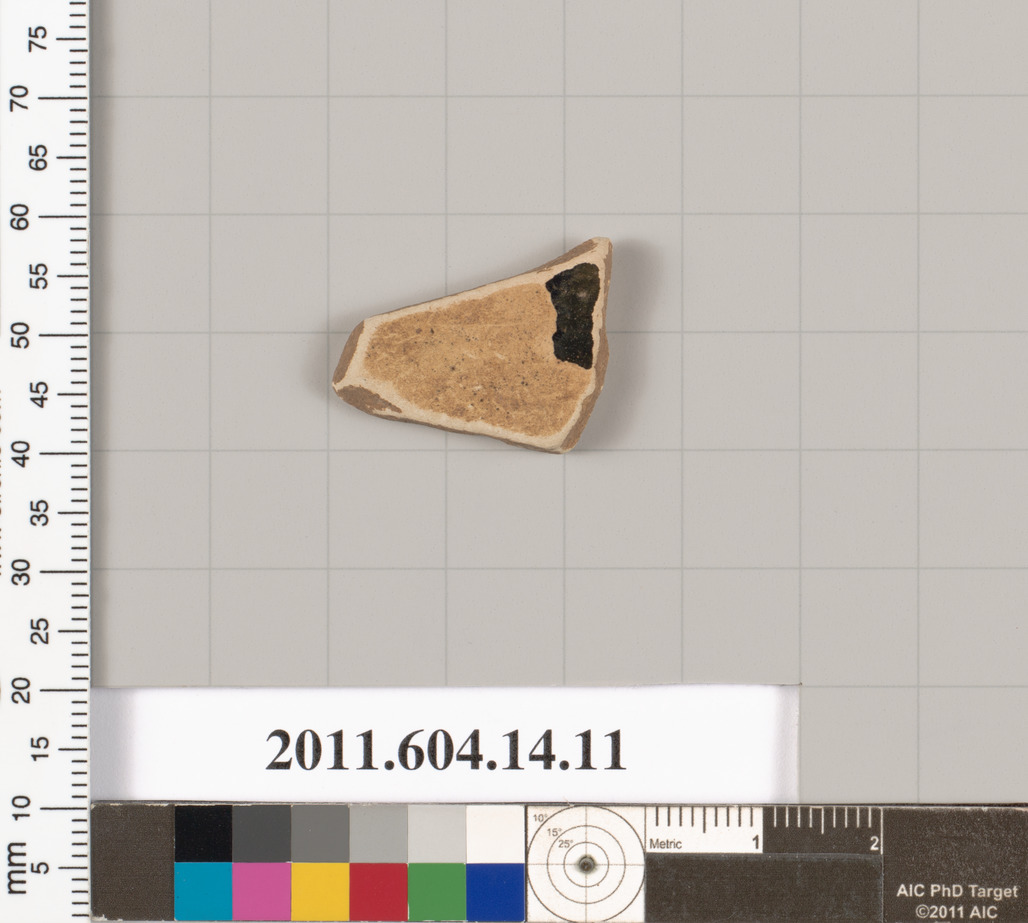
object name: undetermined open shape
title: Terracotta fragment of an open shape?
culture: unknown fabric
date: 600-501 BCE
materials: terracotta